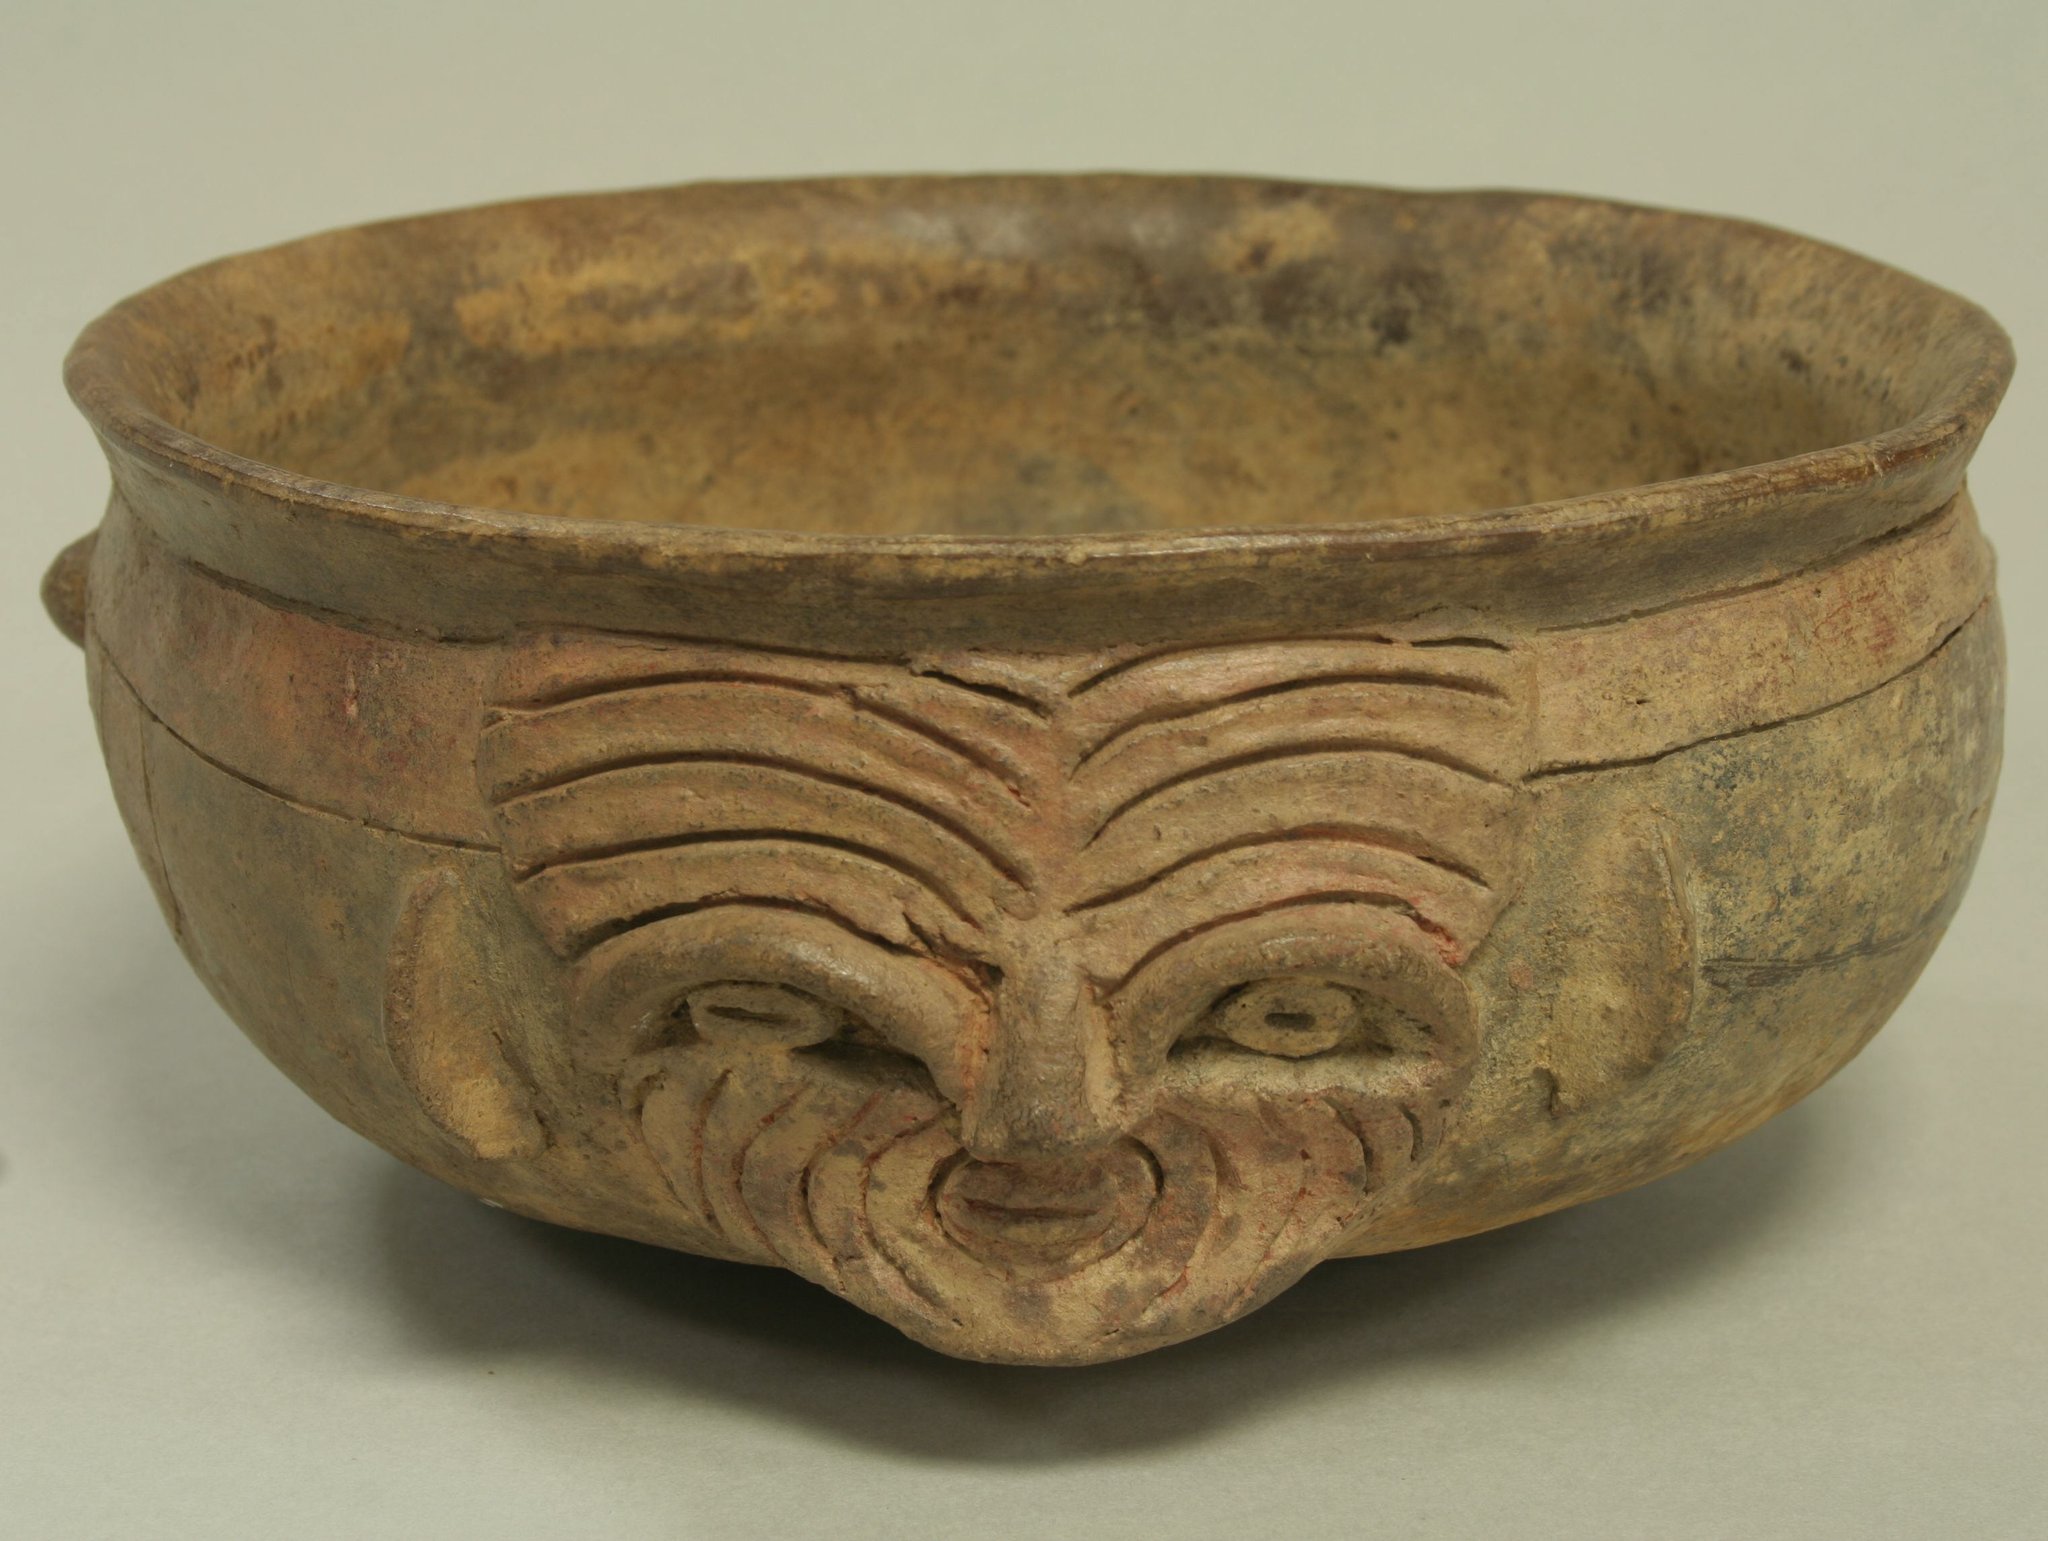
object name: bowl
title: Bowl with Face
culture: chavin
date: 500-301 BCE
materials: ceramic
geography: peru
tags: faces